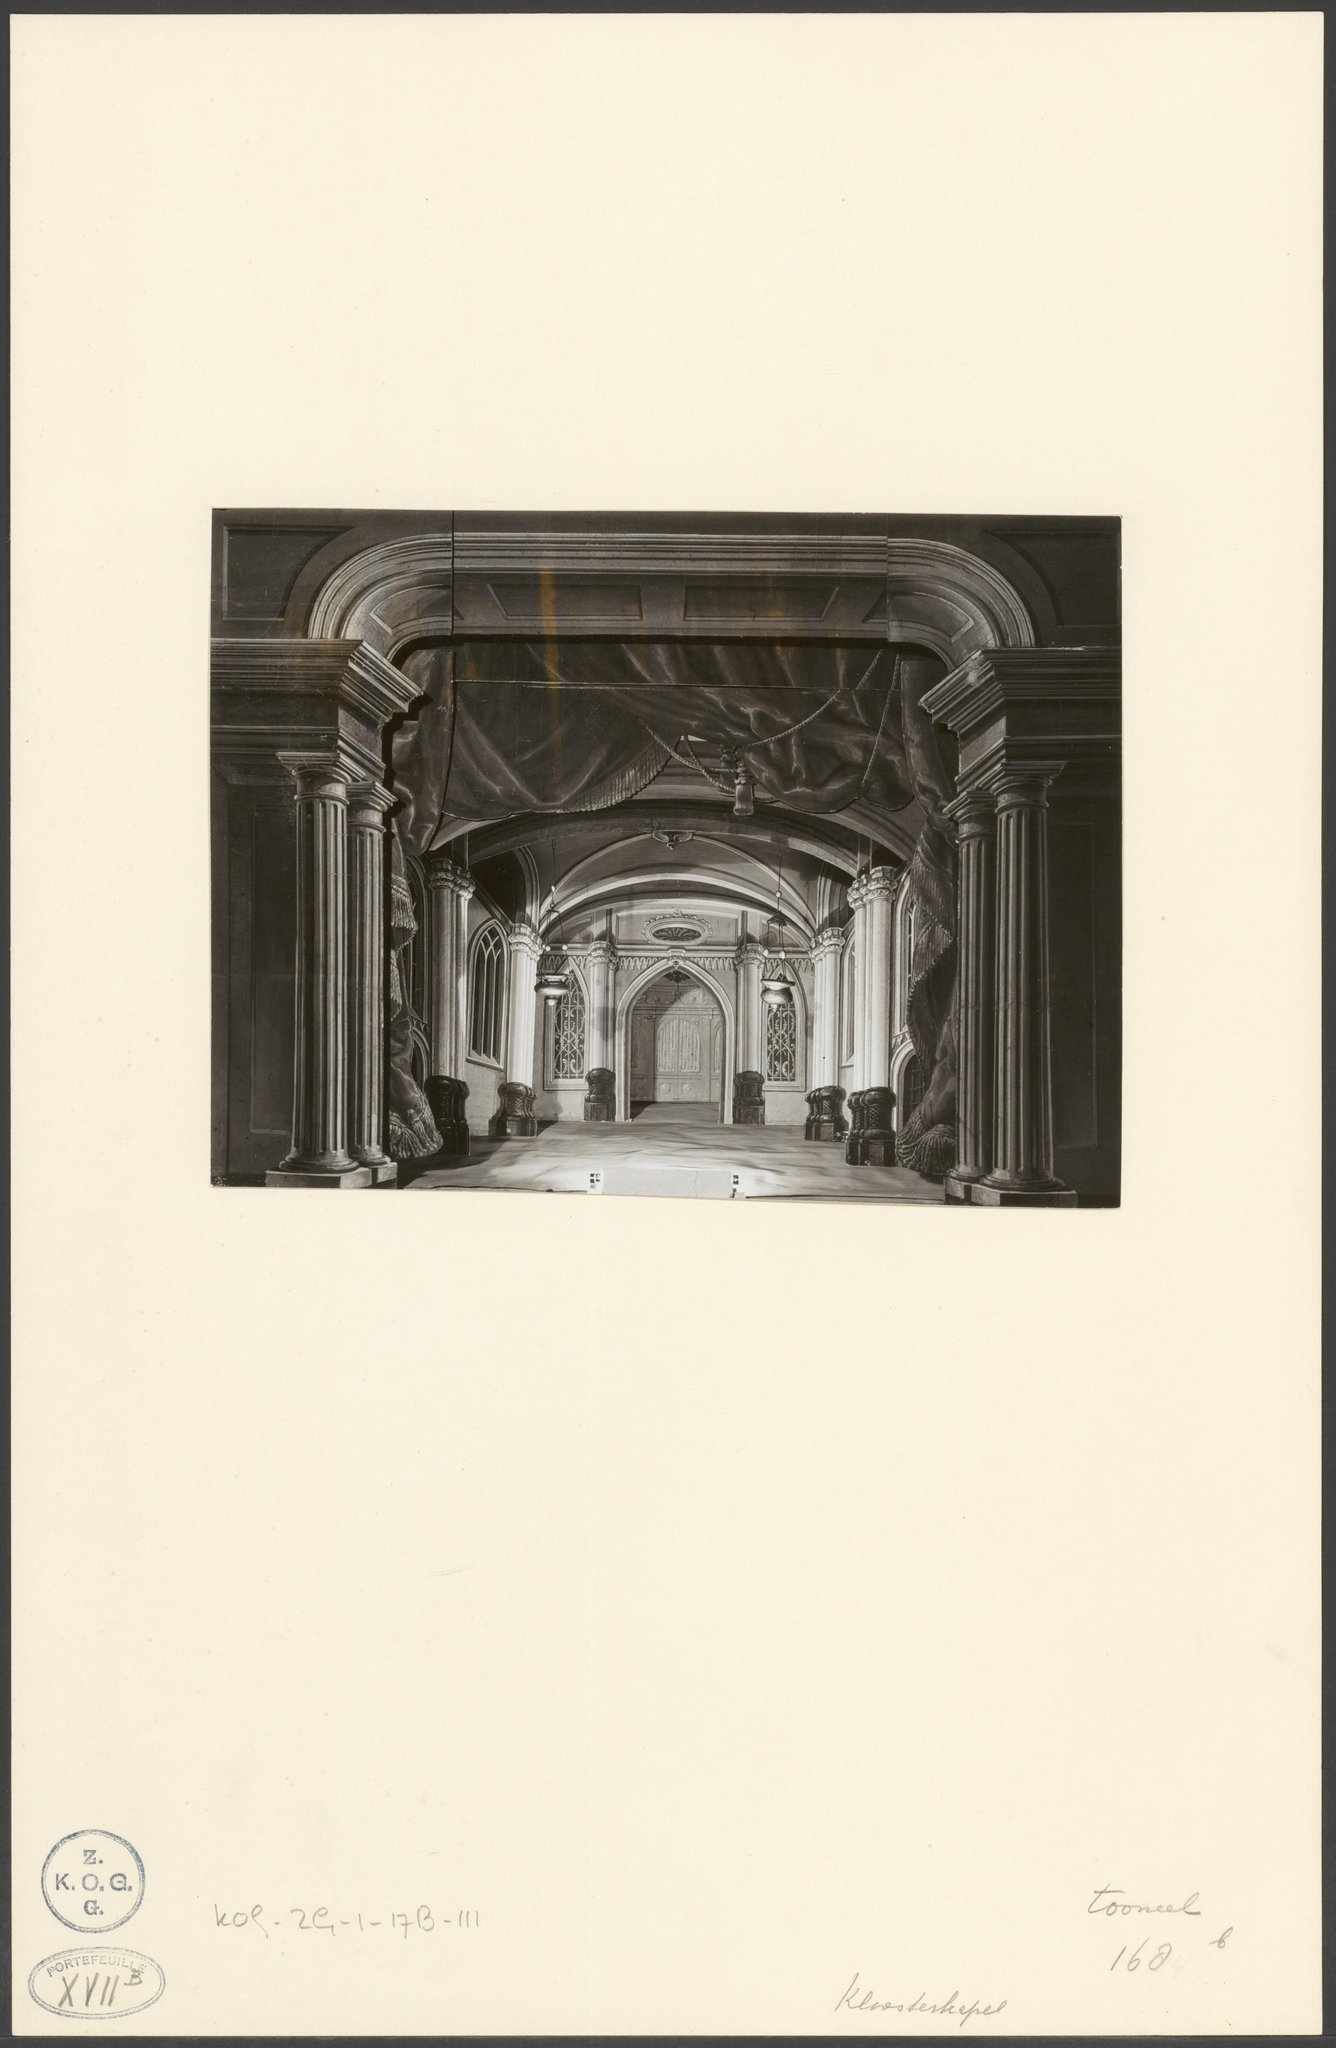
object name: photograph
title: Toneeldecor: Kloosterkoepel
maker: Anonymous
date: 1880-1949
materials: paper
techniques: gelatin silver print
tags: theatre, theatrical performance, stage design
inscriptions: collector's mark: Lugt 1641, stamp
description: Toneeldecor van de Kloosterkoepel uit de Gijsbrecht van Amstel. Decor voor de Schouwburg op het Leidseplein. Onderwerpsrubrieken binnen de Atlas Zeden en Gewoonten: Schoone kunsten, Tooneel, Decors voor de Schouwburg.